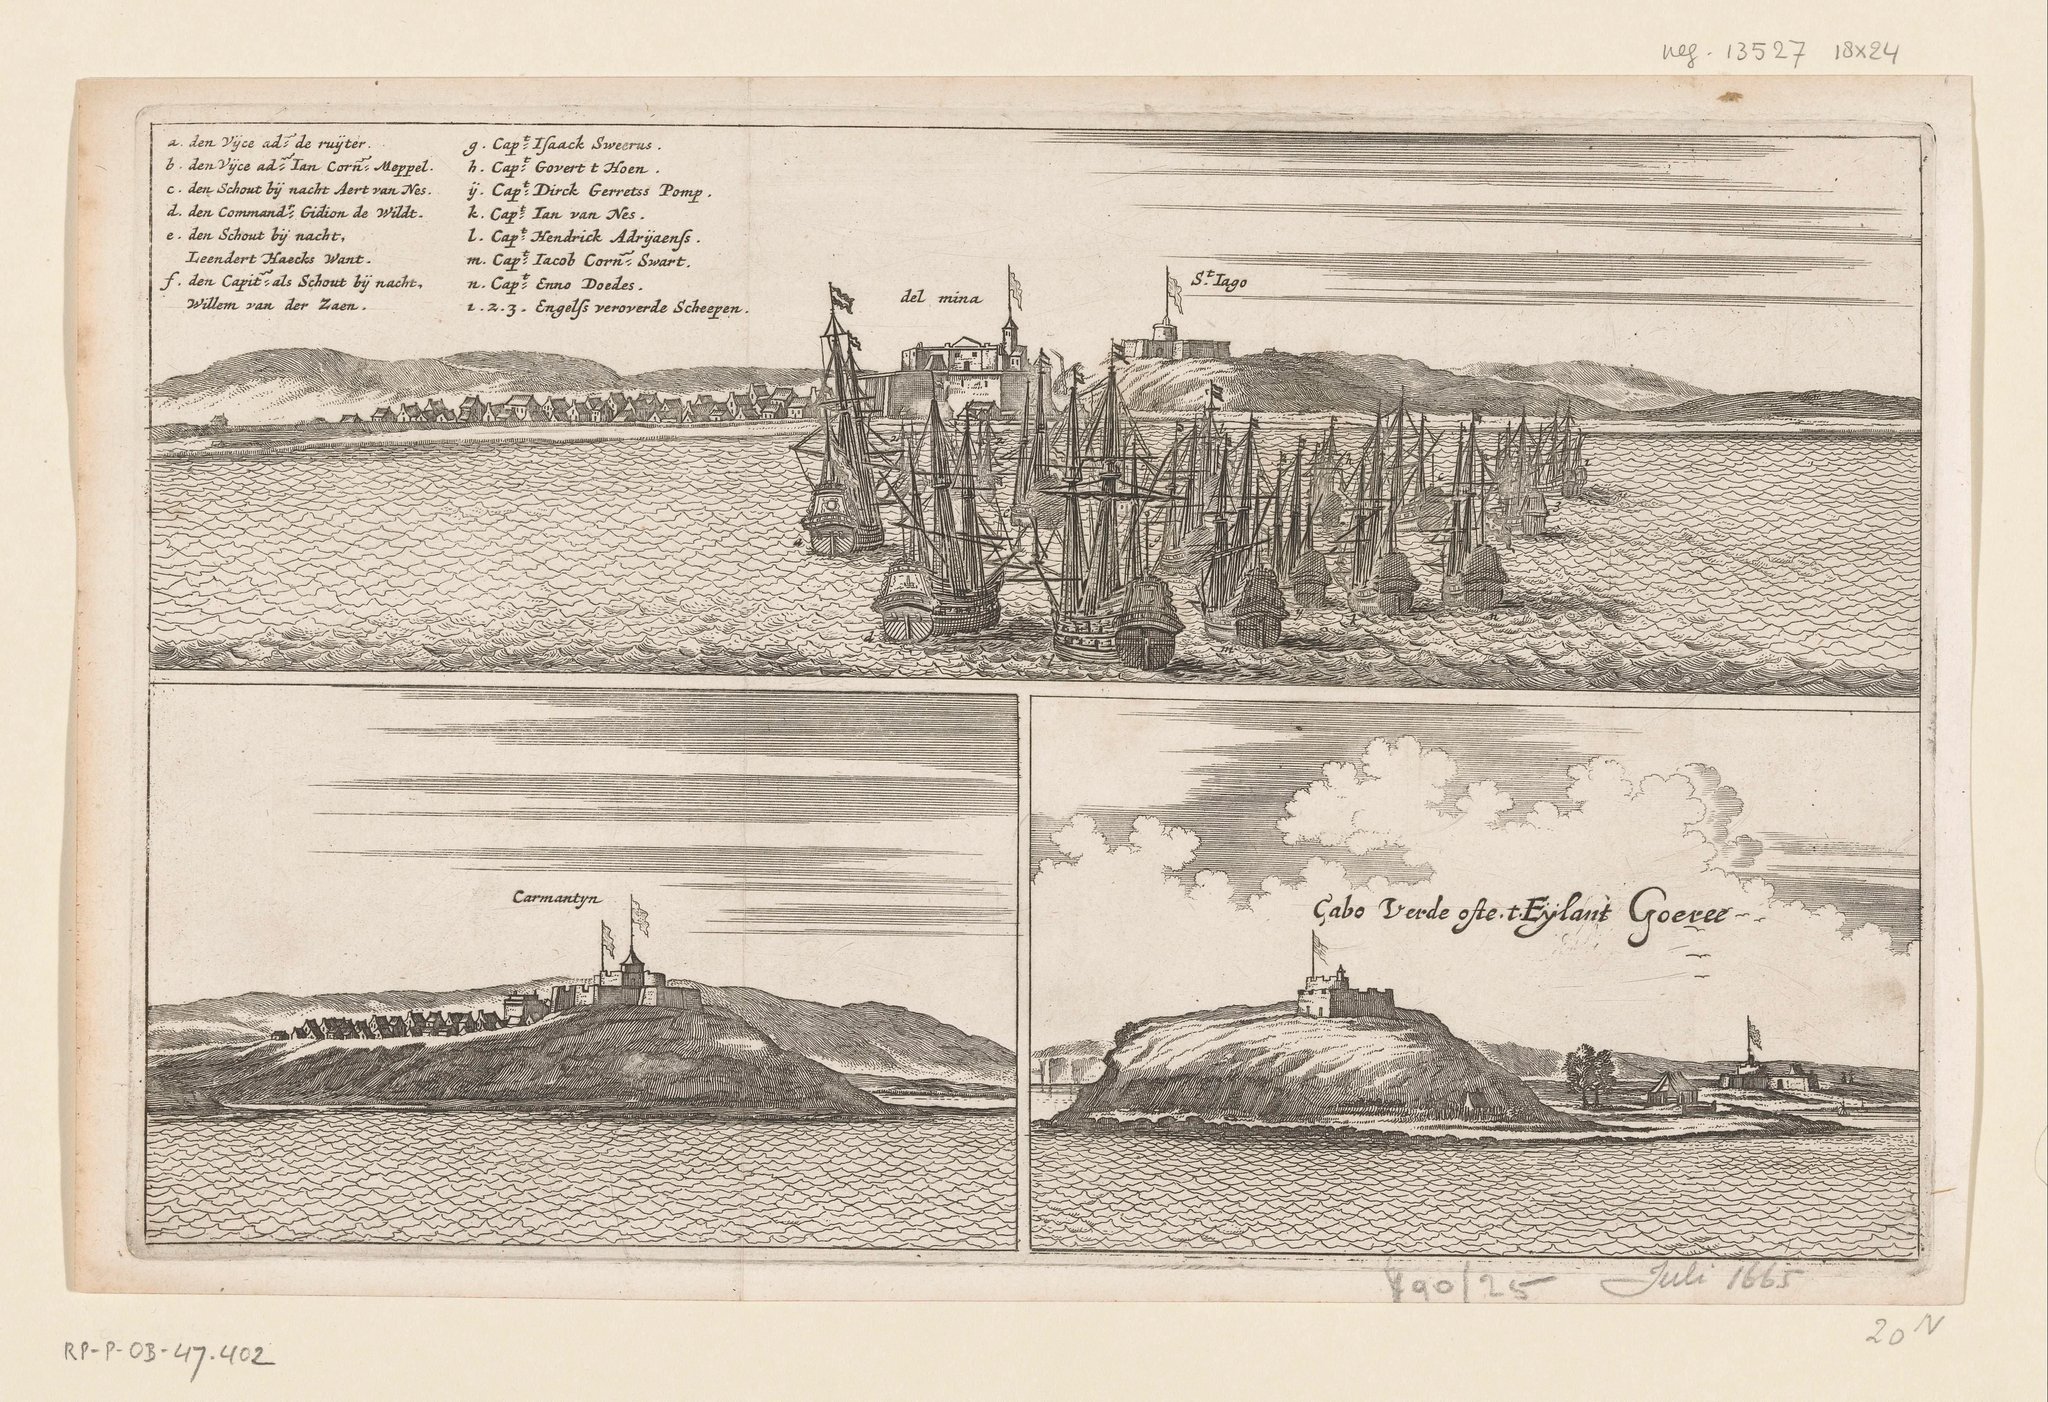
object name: print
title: Gezicht op Elmina, Cormantijn en het eiland Goeree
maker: Anonymous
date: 1665-1670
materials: paper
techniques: engraving, etching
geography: northern netherlands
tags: flushing, michiel adriaenszoon de ruyter, fortress, sailing-ship, sailing-boat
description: Blad met drie voorstellingen, juli 1665. Boven: de Nederlandse vloot onder admiraal Michiel Adriaenszoon de Ruyter met drie veroverde Engelse schepen voor kasteel St. Iago te Elmina, linksboven de legenda a-n. Linksonder: gezicht op het fort Cormantijn aan de Afrikaanse Goudkust. Rechtsonder: gezicht op het eiland Goeree in de Cabo Verde voor de kust van Senegal.